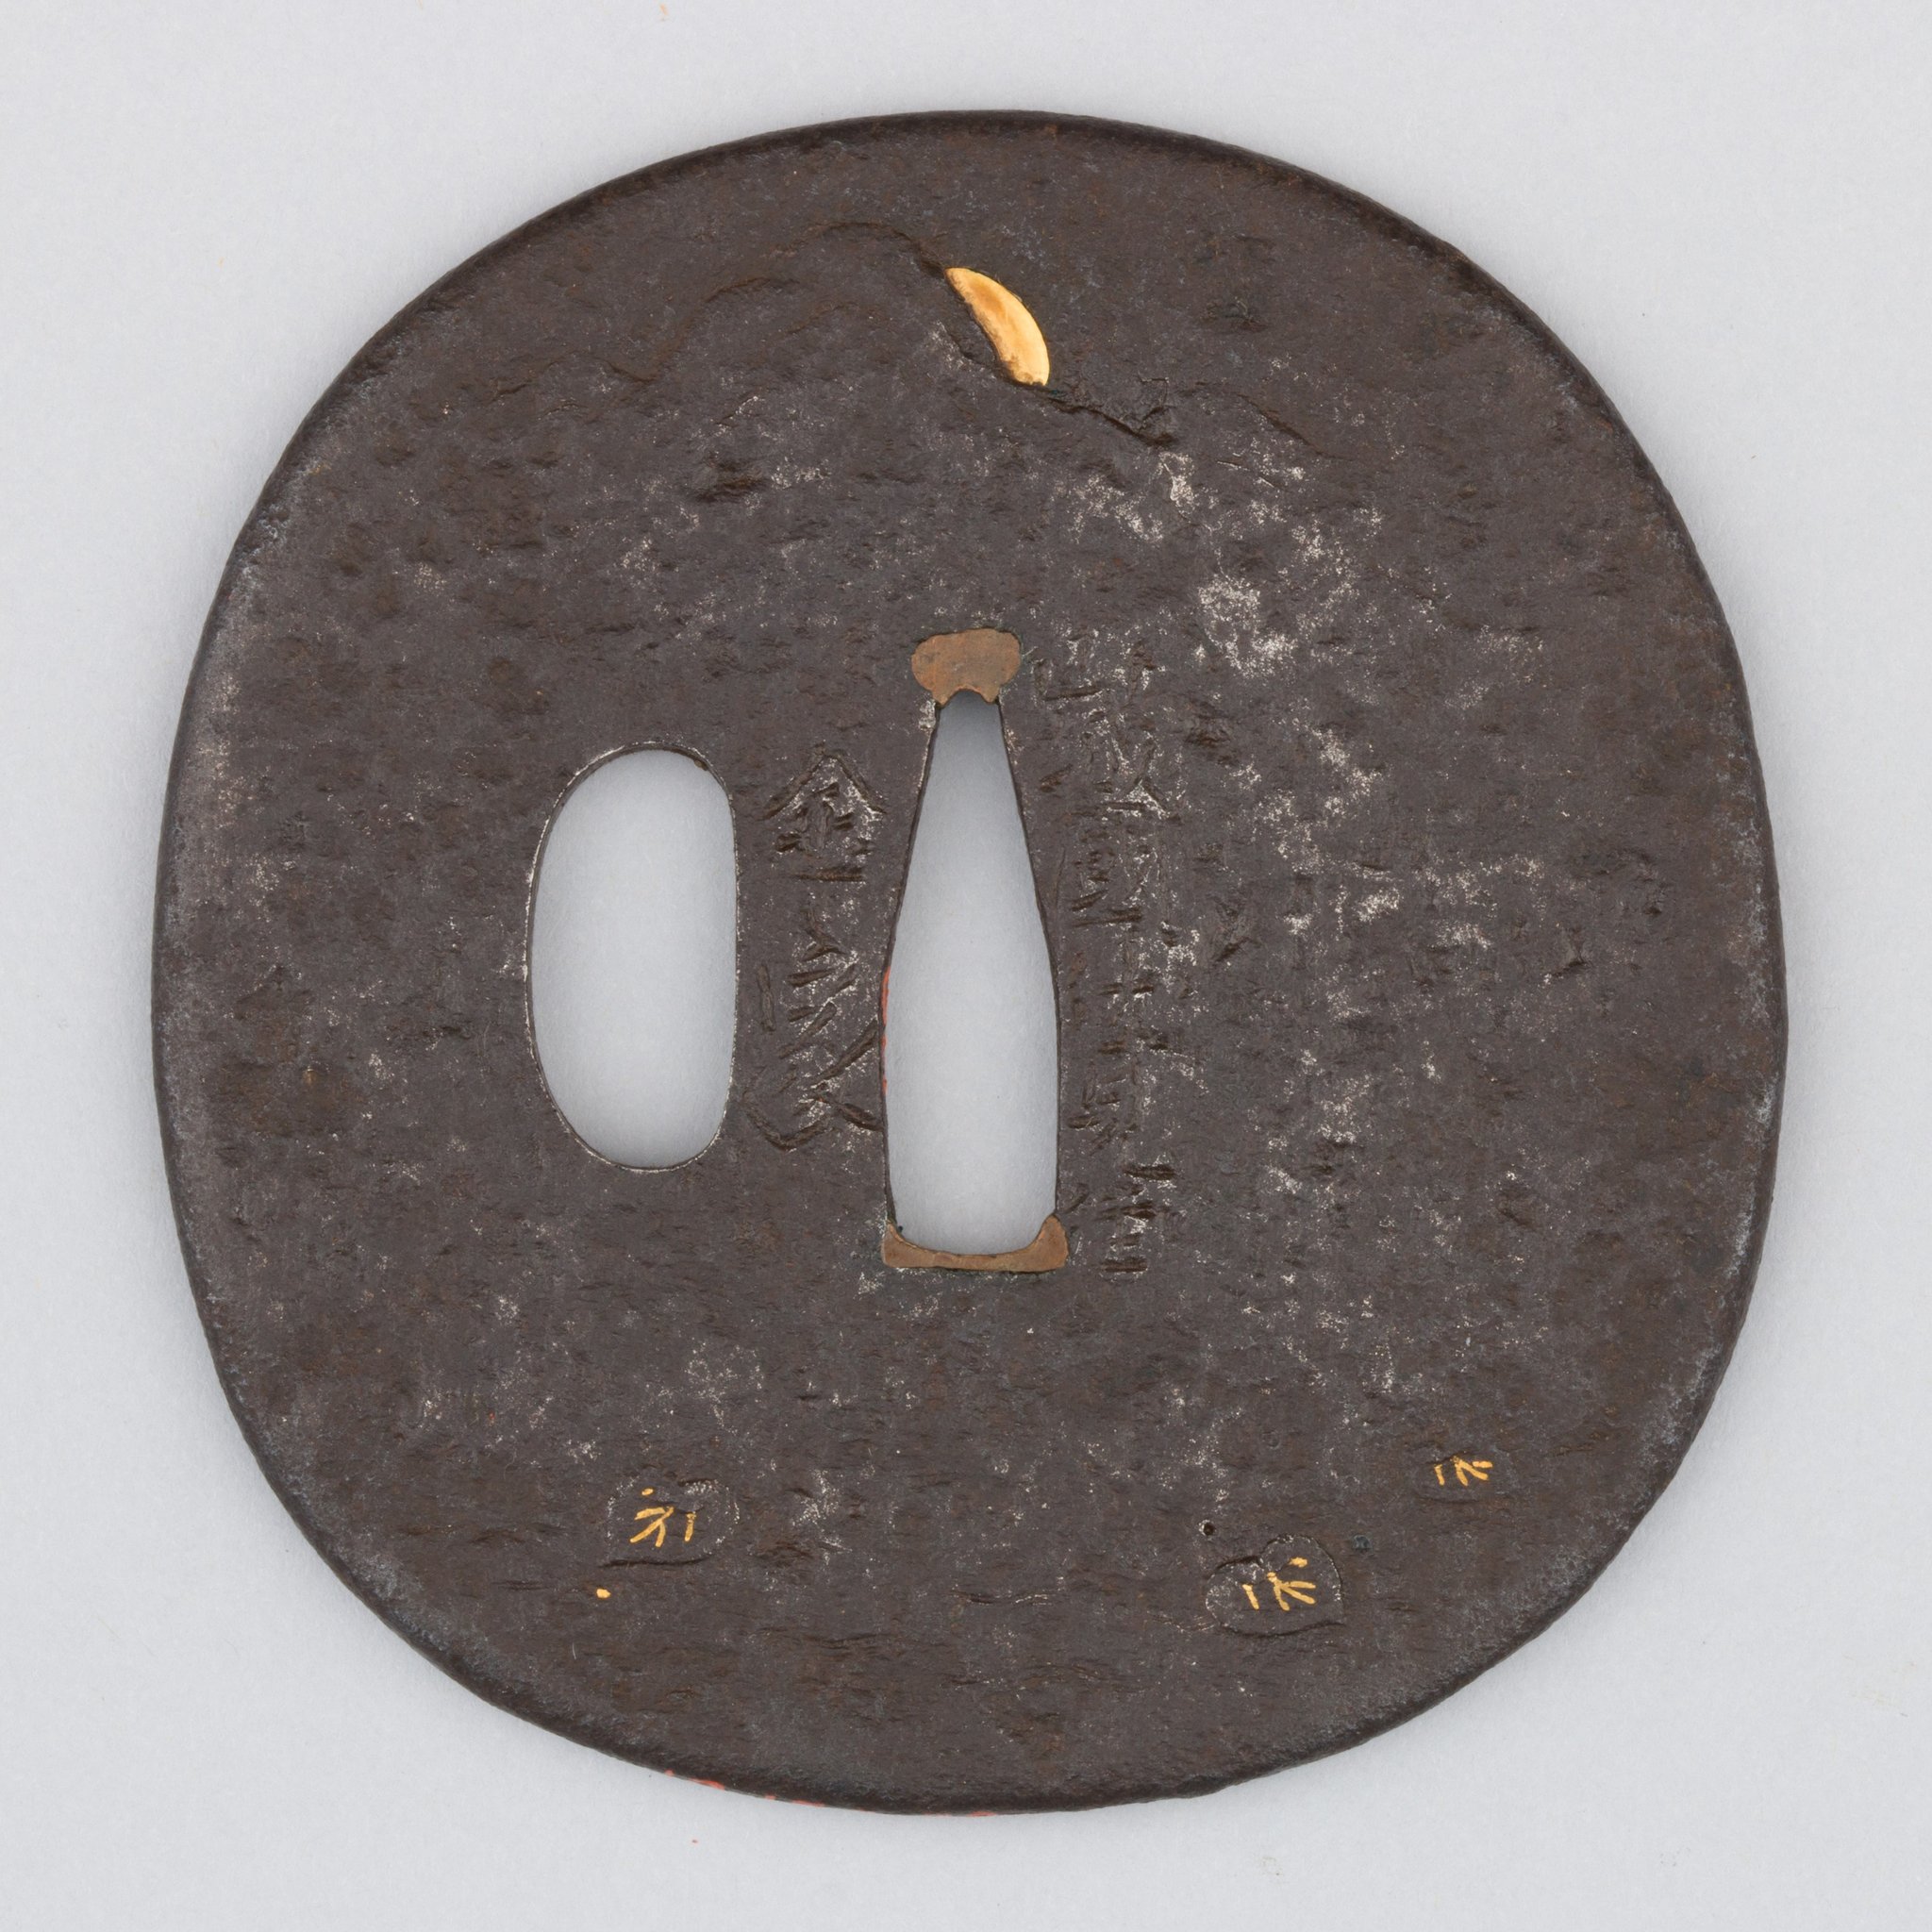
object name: sword guard tsuba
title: Sword Guard (Tsuba)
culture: japanese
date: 1601-1700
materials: copper, iron, silver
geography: japan